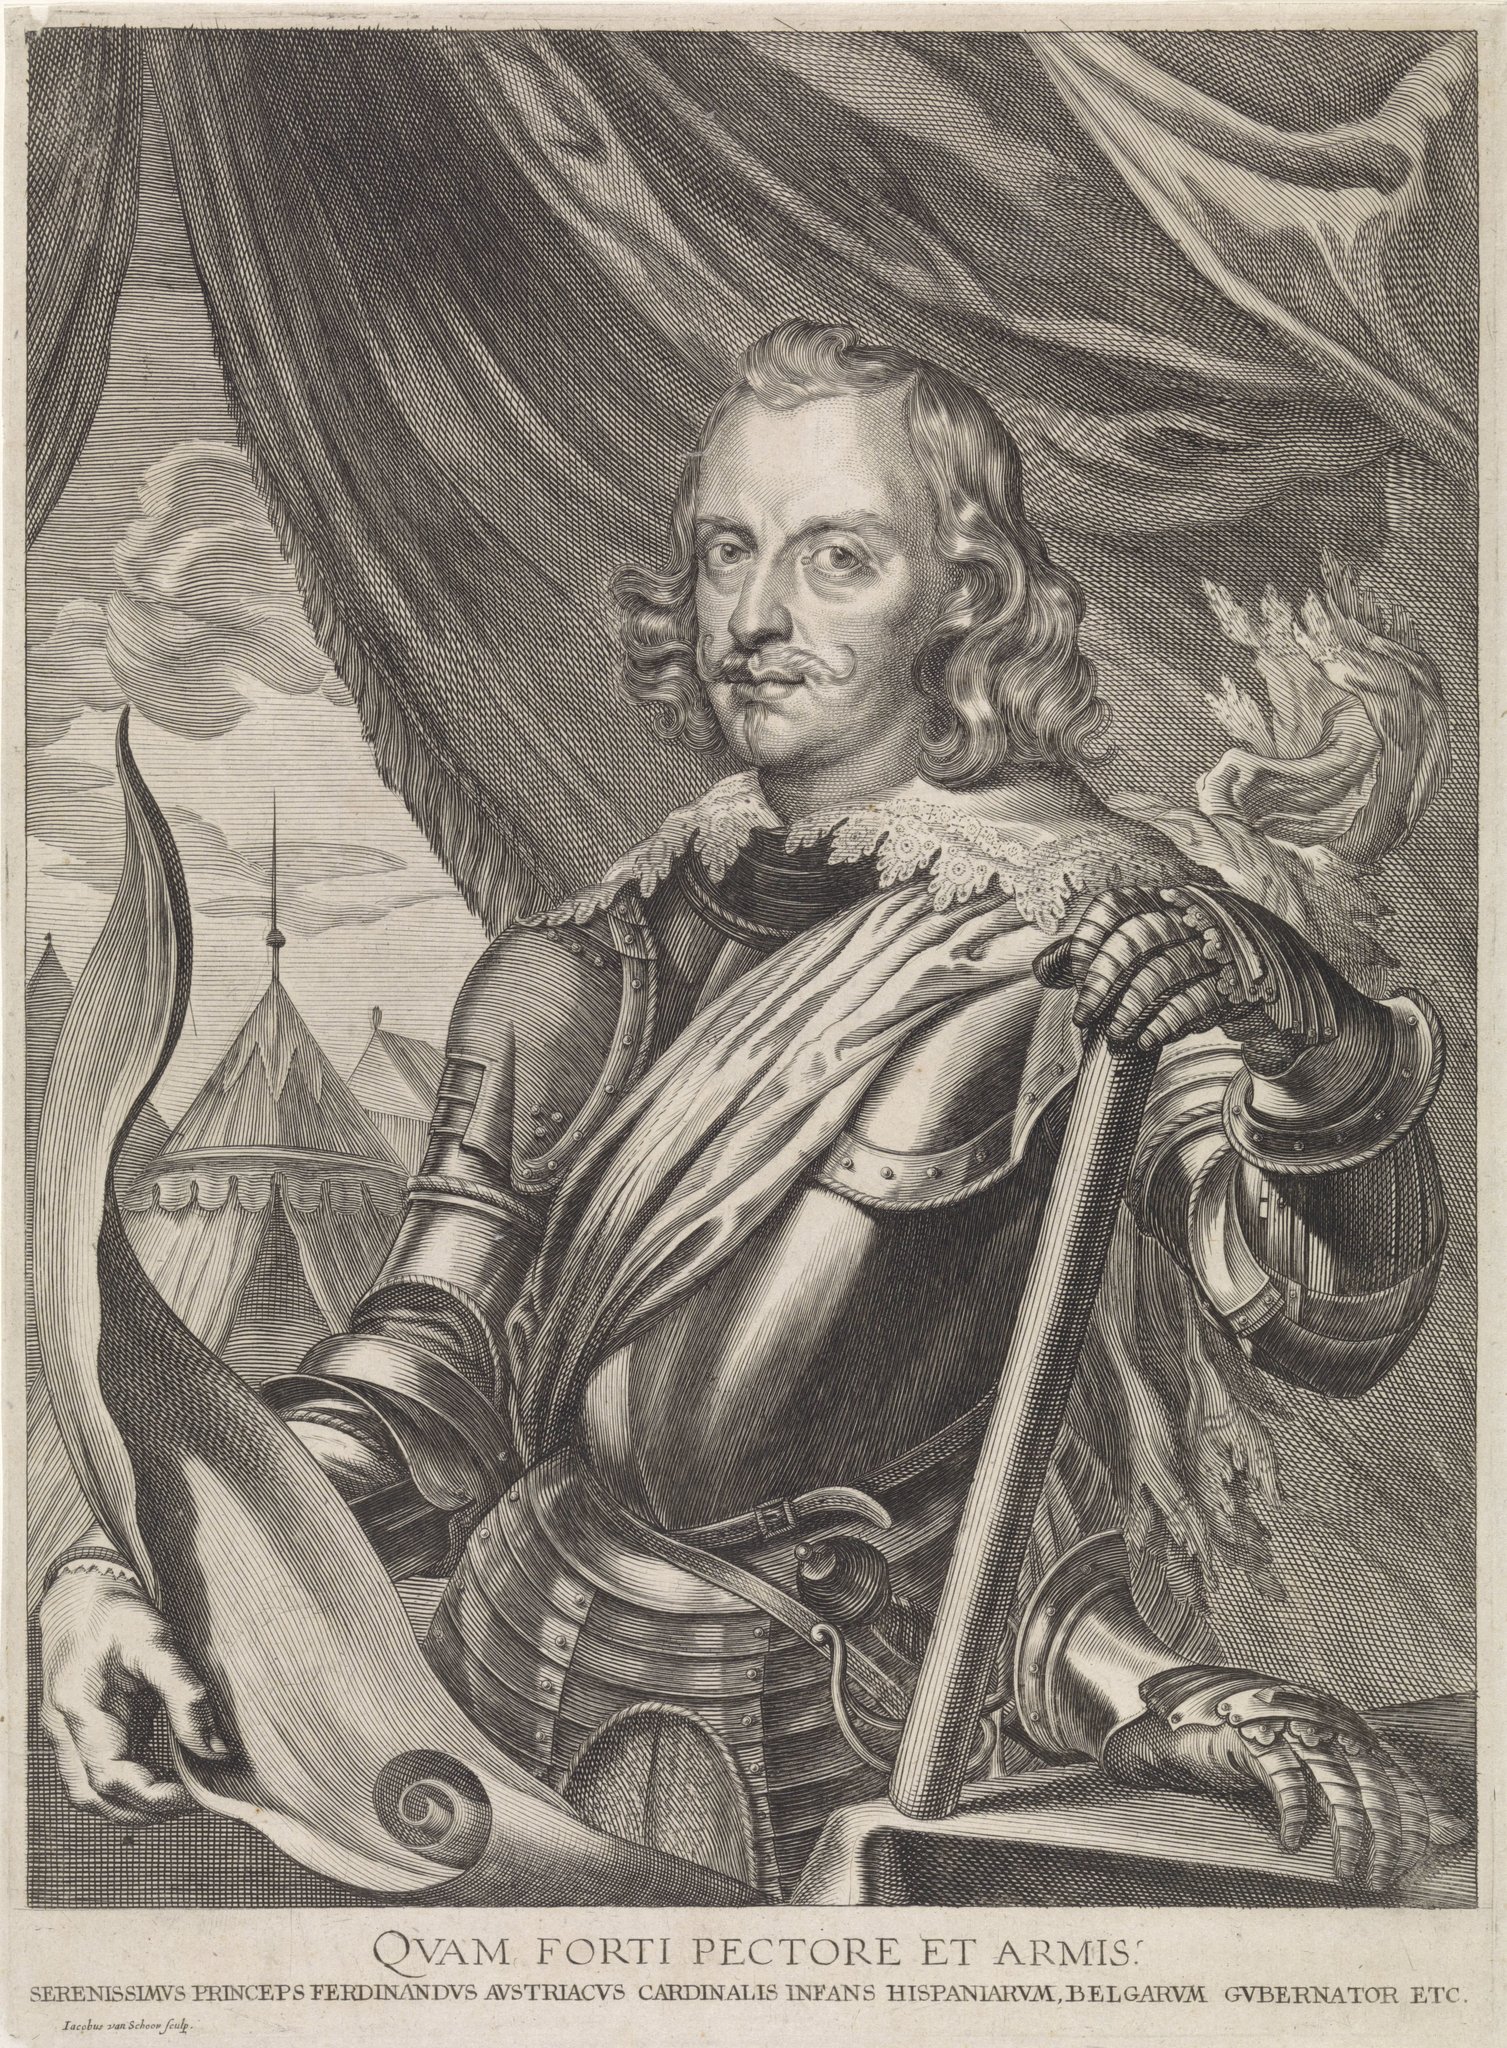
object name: print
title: Portret van Ferdinand van Oostenrijk, landvoogd der zuidelijke Nederlanden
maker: jacobus van schoor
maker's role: print maker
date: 1636-1666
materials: paper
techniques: engraving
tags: landvoogd der zuidelijke nederlanden ferdinand van oostenrijk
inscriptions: collector's mark: Lugt 2228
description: Portret van Ferdinand van Oostenrijk, landvoogd der zuidelijke Nederlanden in harnas. Hij draagt een commandostaf in de ene en een vel papier in de andere hand. Onder het portret een zinsspreuk uit Vergilius. Daaronder zijn naam en functie.